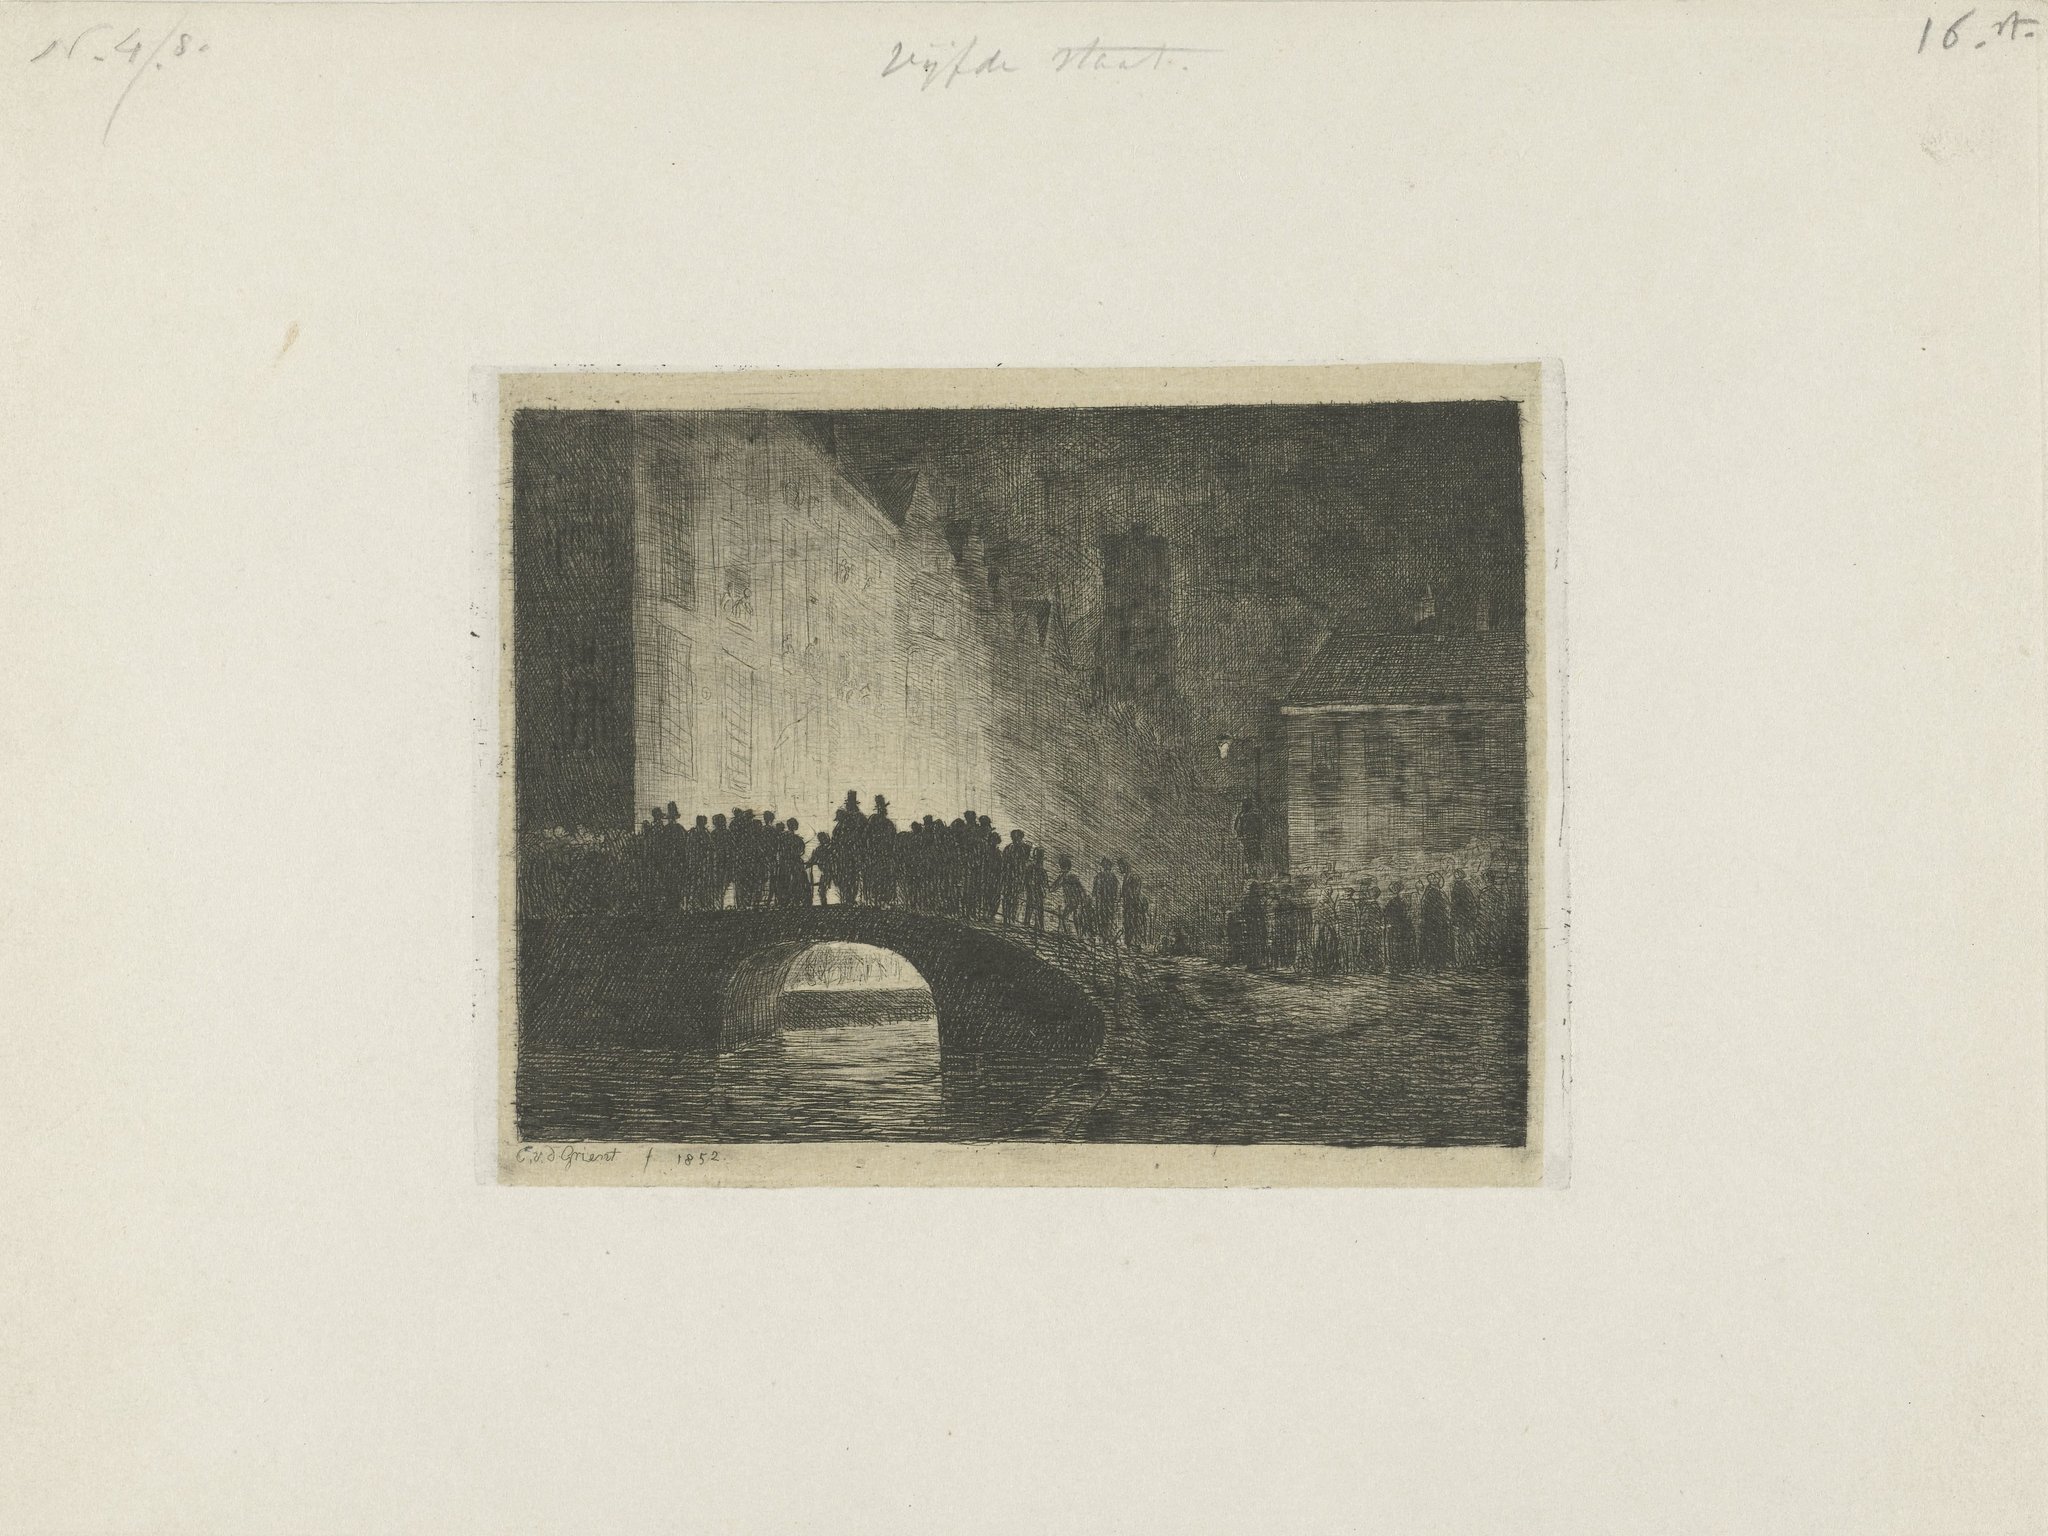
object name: print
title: Serenade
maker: cornelis van der griendt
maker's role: draughtsman, painter, print maker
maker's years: 1827-1918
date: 1852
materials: paper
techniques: etching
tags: city-view in general; 'veduta' - ii - ideal city (+ city(-scape) with figures, staffage)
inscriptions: collector's mark: Lugt 2228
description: Nachtelijk stadsgezicht met een zanger en toeschouwers.